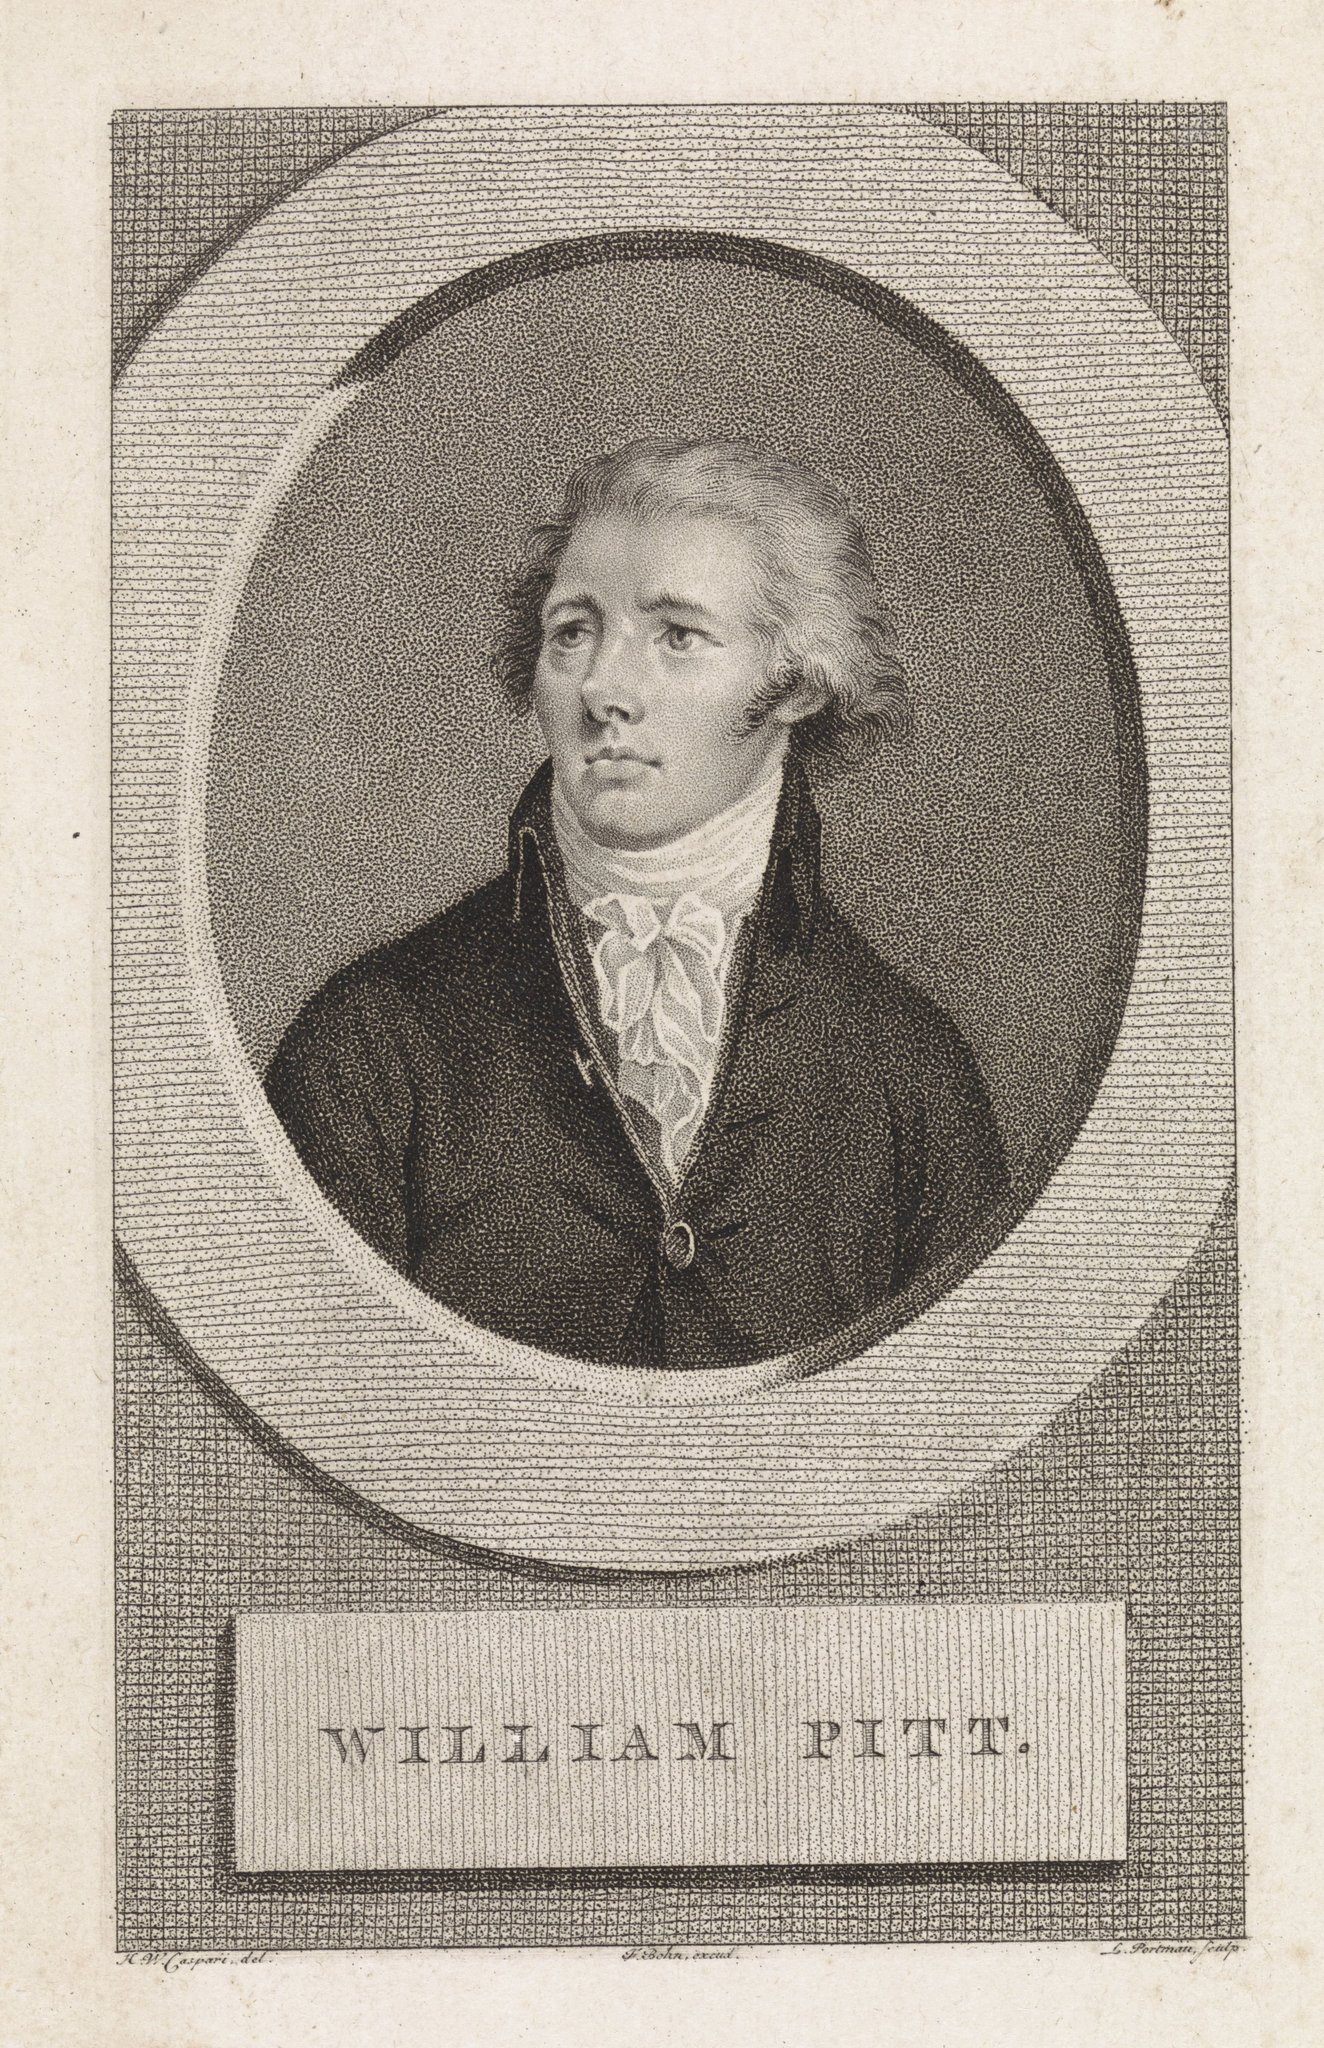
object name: print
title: Portret van William Pitt II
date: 1794-1828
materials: paper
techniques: stippled etching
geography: haarlem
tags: london, politician, historical persons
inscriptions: collector's mark: Lugt 2228